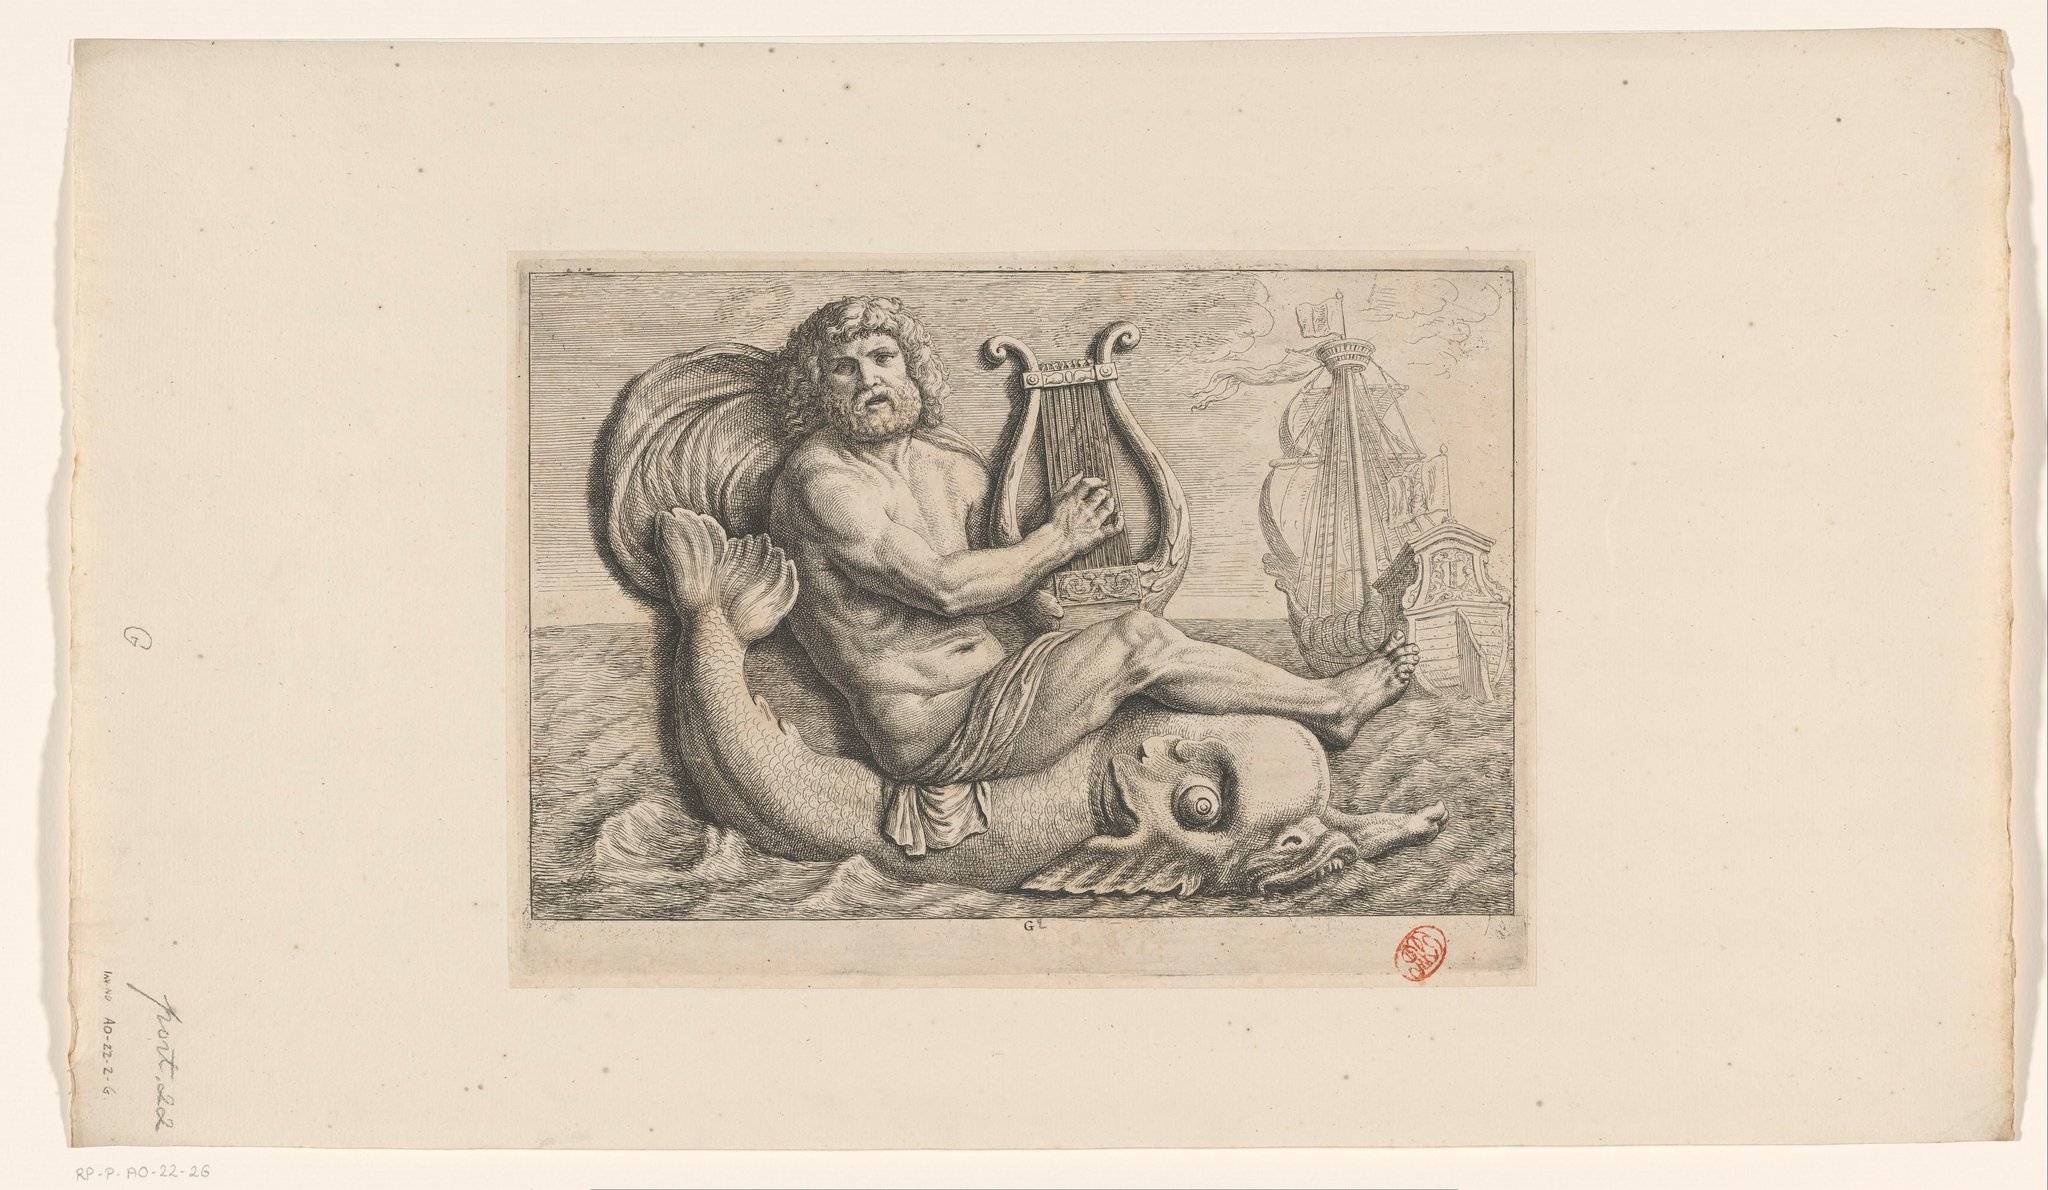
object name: print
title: Reliëf met Arion op de dolfijn boven de deur naar de Assurantiekamer in het Stadhuis op de Dam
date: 1663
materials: paper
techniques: engraving, etching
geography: amsterdam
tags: arion rides on a dolphin, holding his lyre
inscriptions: collector's mark: Lugt 195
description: Prent gebruikt in: Secunca pars Praecipuarum effigierum ac ornamentorum amplissime Curiae Amstelrodamensis maiori ex parte in cadido marmore effectorum per Artum Quellinium eiusdem Civitatis Statuarium / Het tweede deel Van de voornaemste Statuen ende Cieraten van 't konst-rijcke Stadt-huys van Amstelredam 'tmeeste in Marmer gemaeckt door Artus Quellinus Beelthouwer der voorseyde Stadt. Amsterdam: Artus Quellinus (I), 1663. Zie RP-P-AO-22-2-1 voor bijhorende titelpagina. Zie RP-P-AO-22-2-2 voor bijhorend register. Zie RP-P-AO-22-2A, RP-P-AO-22-2B, RP-P-AO-22-2C-1, RP-P-AO-22-2C-2, RP-P-AO-22-2C-3, RP-P-AO-22-2C-4, RP-P-AO-22-2D-1, RP-P-AO-22-2D-2, RP-P-AO-22-2D-3, RP-P-AO-22-2E-1, RP-P-AO-22-2E-2, RP-P-AO-22-2E-3, RP-P-AO-22-2E-4, RP-P-AO-22-2F-1, RP-P-AO-22-2F-2, RP-P-AO-22-2F-3, RP-P-AO-22-2H, RP-P-AO-22-2I, RP-P-AO-22-2K, RP-P-AO-22-2L, RP-P-AO-22-2M, RP-P-AO-22-2N, RP-P-AO-22-2O-1, RP-P-AO-22-2O-2, RP-P-AO-22-2O-3, RP-P-AO-22-2O-4, RP-P-AO-22-2O-5, RP-P-AO-22-2O-6, RP-P-AO-22-2O-7, RP-P-AO-22-2P-1, RP-P-AO-22-2P-2, RP-P-AO-22-2Q-1, RP-P-AO-22-2Q-2, RP-P-AO-22-2Q-3, RP-P-AO-22-2R-1, RP-P-AO-22-2R-2, RP-P-AO-22-2R-3, RP-P-AO-22-2S, RP-P-AO-22-2T-1, RP-P-AO-22-2T-2, RP-P-AO-22-2T-3, RP-P-AO-22-2T-4, RP-P-AO-22-2V-1, RP-P-AO-22-2V-2, RP-P-AO-22-2W-1, RP-P-AO-22-2W-2, RP-P-AO-22-2X-1, RP-P-AO-22-2X-2 en RP-P-AO-22-2X-3 voor andere prenten uit deze publicatie. Zelfde staat van prent ook gebruikt in: Secunca pars Praecipuarum effigierum ac ornamentorum amplissime Curiae Amstelrodamensis maiori ex parte in cadido marmore effectorum per Artum Quellinium eiusdem Civitatis Statuarium / Het tweede deel Van de voornaemste Statuen ende Cieraten van 't konst-rijcke Stadt-huys van Amstelredam 'tmeeste in Marmer gemaeckt door Artus Quellinus Beelthouwer der voorseyde Stadt. Amsterdam: Frederik de Wit, 1668. Latere staat van prent ook gebruikt in: Architecture peinture et sculpture de la Maison de Ville d'Amsterdam, representee en CIX. figures en taille-douce (…). Amsterdam: David Mortier, 1719. En in: Architecture peinture et sculpture de la Maison de Ville d'Amsterdam, representee en CIX. figures en taille-douce (…). Amsterdam: Gerard Valck, 1719. En in: Bouw schilder en beeldhouwkonst, van het Stadhuis te Amsteldam, vertoont in CIX figuuren (…). Amsterdam: Covens & Mortier & Covens Jr., s.a. (1774-1783). Zie BK-X-2 voor model van beeld.